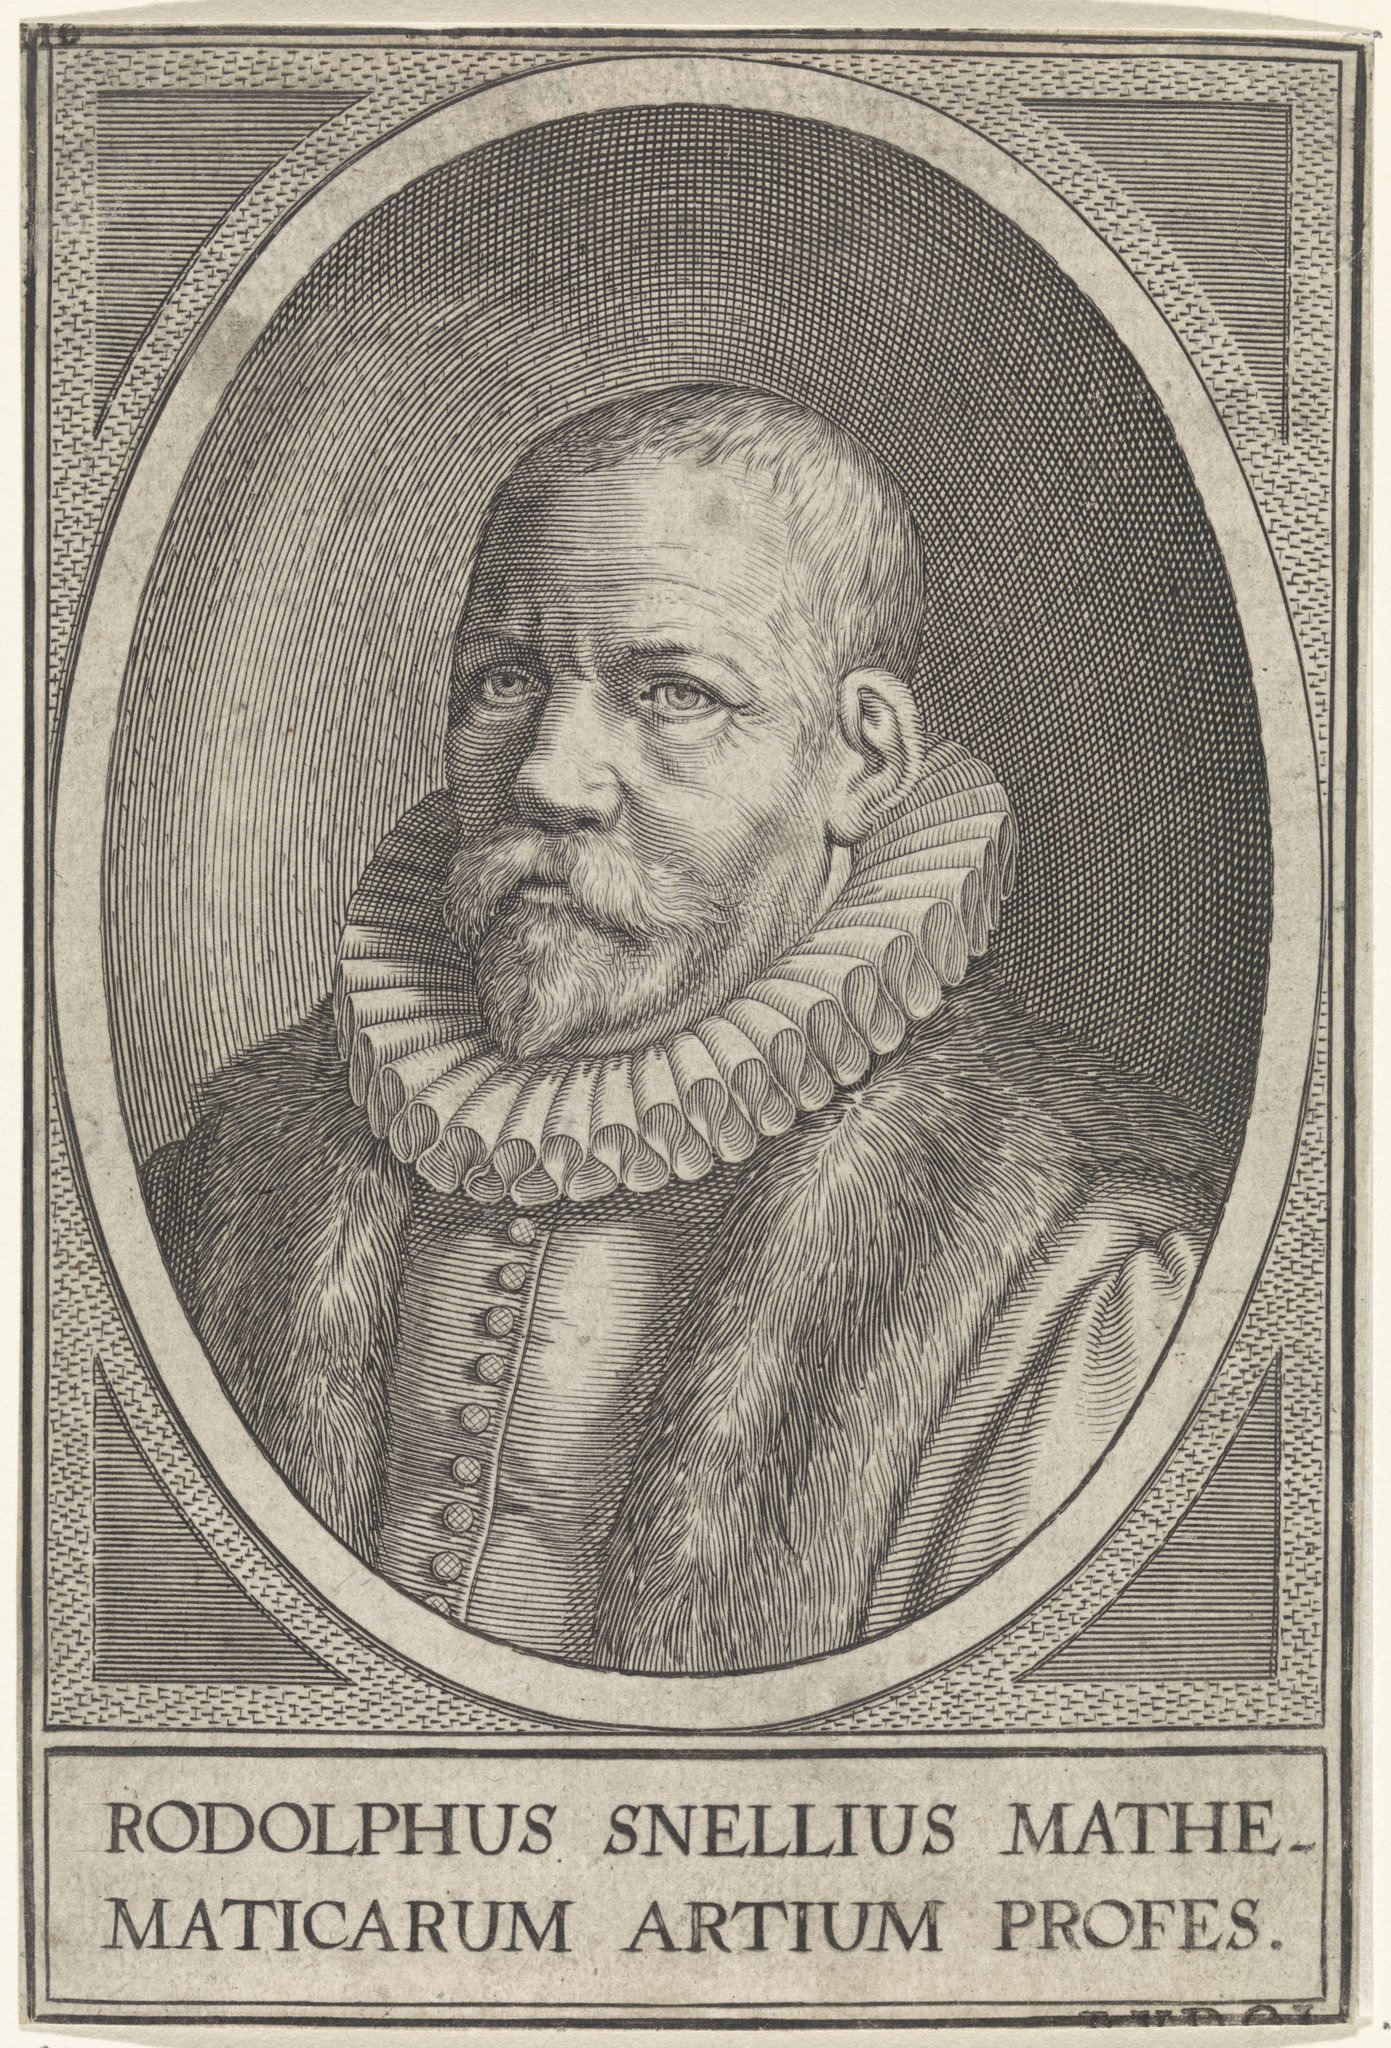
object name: print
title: Portret van Rudolph Snellius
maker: de passe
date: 1625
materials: paper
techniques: engraving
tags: oudewater, rudolph snellius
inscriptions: collector's mark: Lugt 2228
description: Prent mogelijk gebruikt als boekillustratie in: Meursius, Joannes. Athenæ Batavæ. Sive, De vrbe Leidensi, & academiâ, virisque claris. Leiden: Andries Clouck, Bonaventura en Abraham Elzevier, 1625.